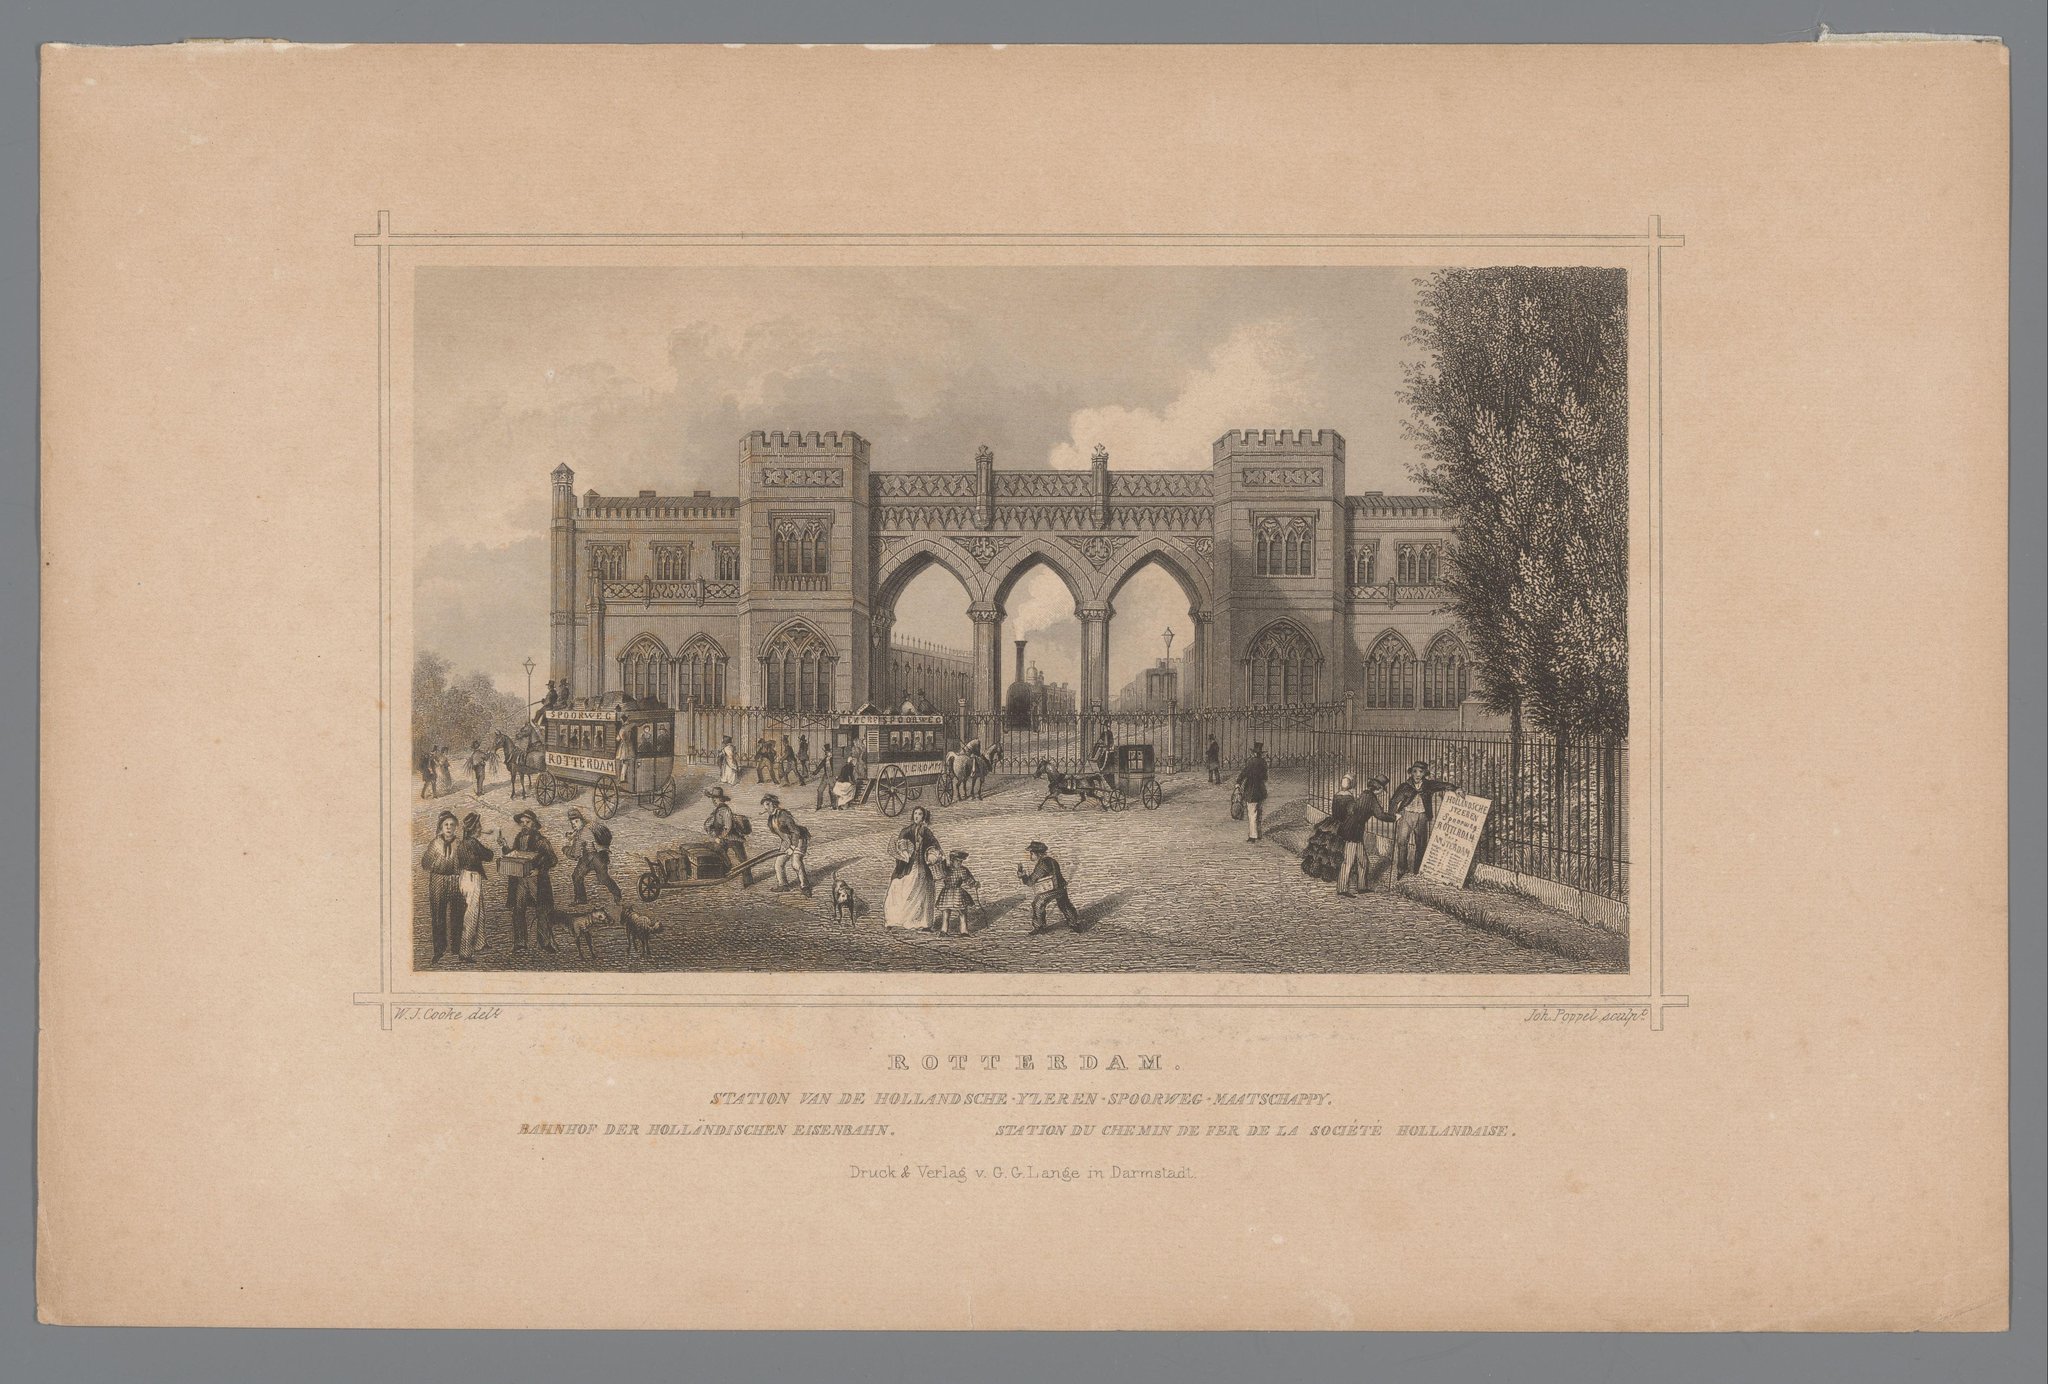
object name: print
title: Rotterdam. Station van de Hollandsche-Yzeren-Spoorweg-maatschappy / Bahnhof der Holländischen Eisenbahn / Station du chemin de fer de la société Hollandaise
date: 1863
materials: paper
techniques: engraving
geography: darmstadt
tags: diligence, omnibus, horse-tram, station; shelter (railway, tramway)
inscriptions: collector's mark: Lugt 2233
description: Prent uit: Der Rhein und die Rheinlande in malerischen Original-Ansichten (...). 3 dln. Darmstadt: G.G. Lange, 1863, dl. 3, p. 158-159.